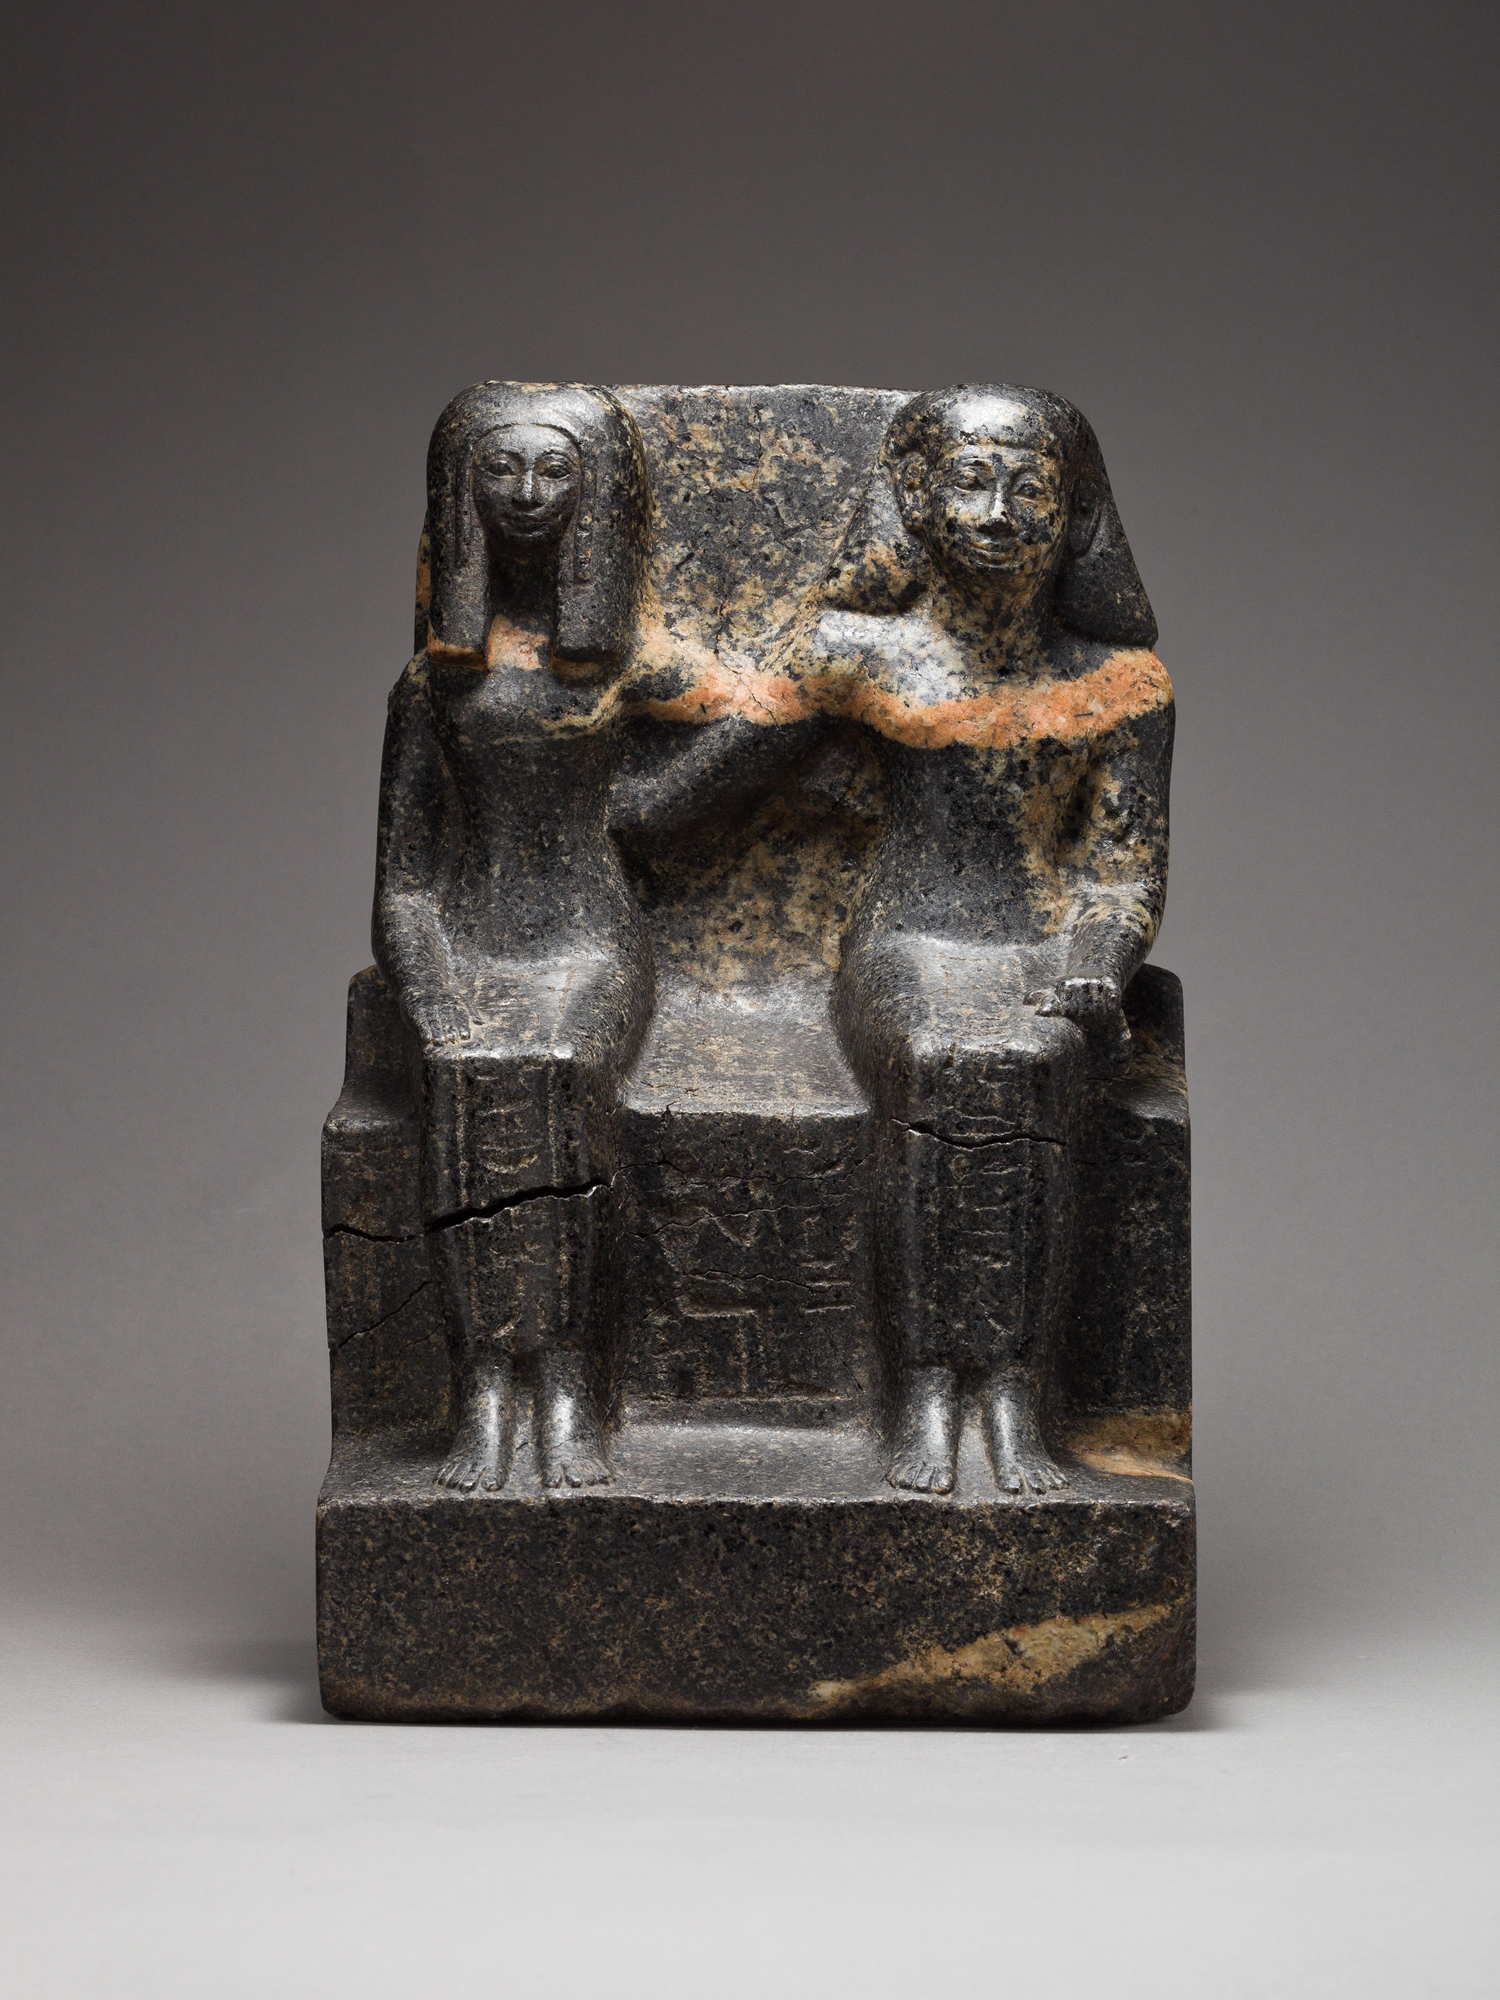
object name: statue, pair, neferkhawet, rennefer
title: Pair Statue of Neferkhawet and Rennefer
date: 1479-1450 BCE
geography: upper egypt, thebes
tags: men,women,hieroglyphs